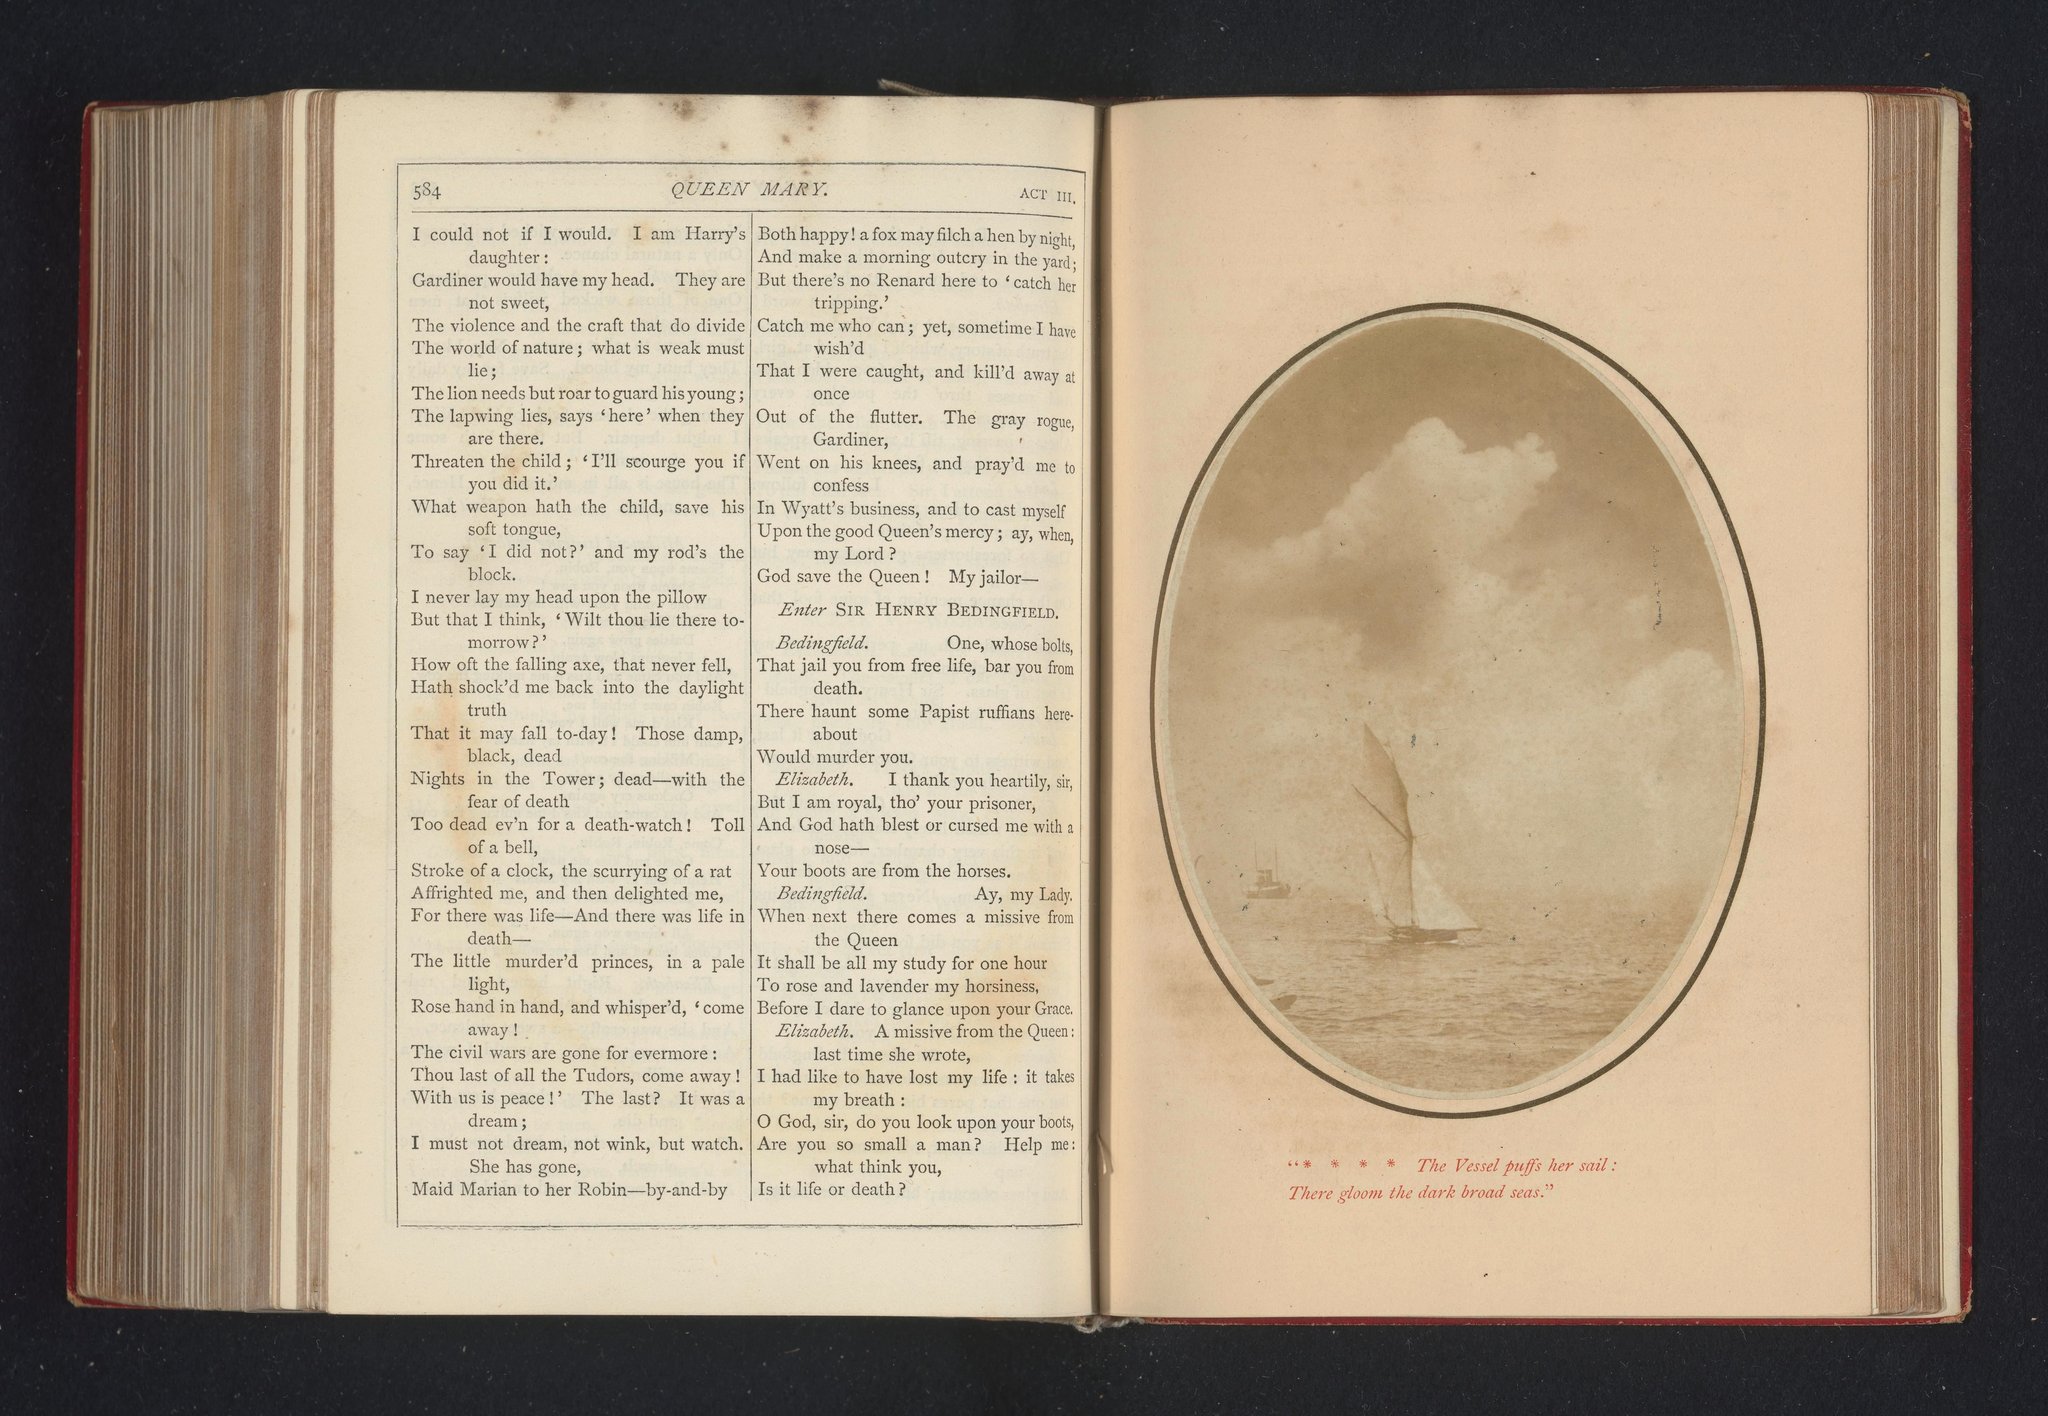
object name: photograph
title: Zeilschip op zee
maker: john payne jennings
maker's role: fotograaf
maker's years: 1843-1926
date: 1873-1878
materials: photographic support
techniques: albumen print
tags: ships (in general)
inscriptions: inscription: ‘"*** The Vessel puffs her sail : There floom the dark broad seas."’